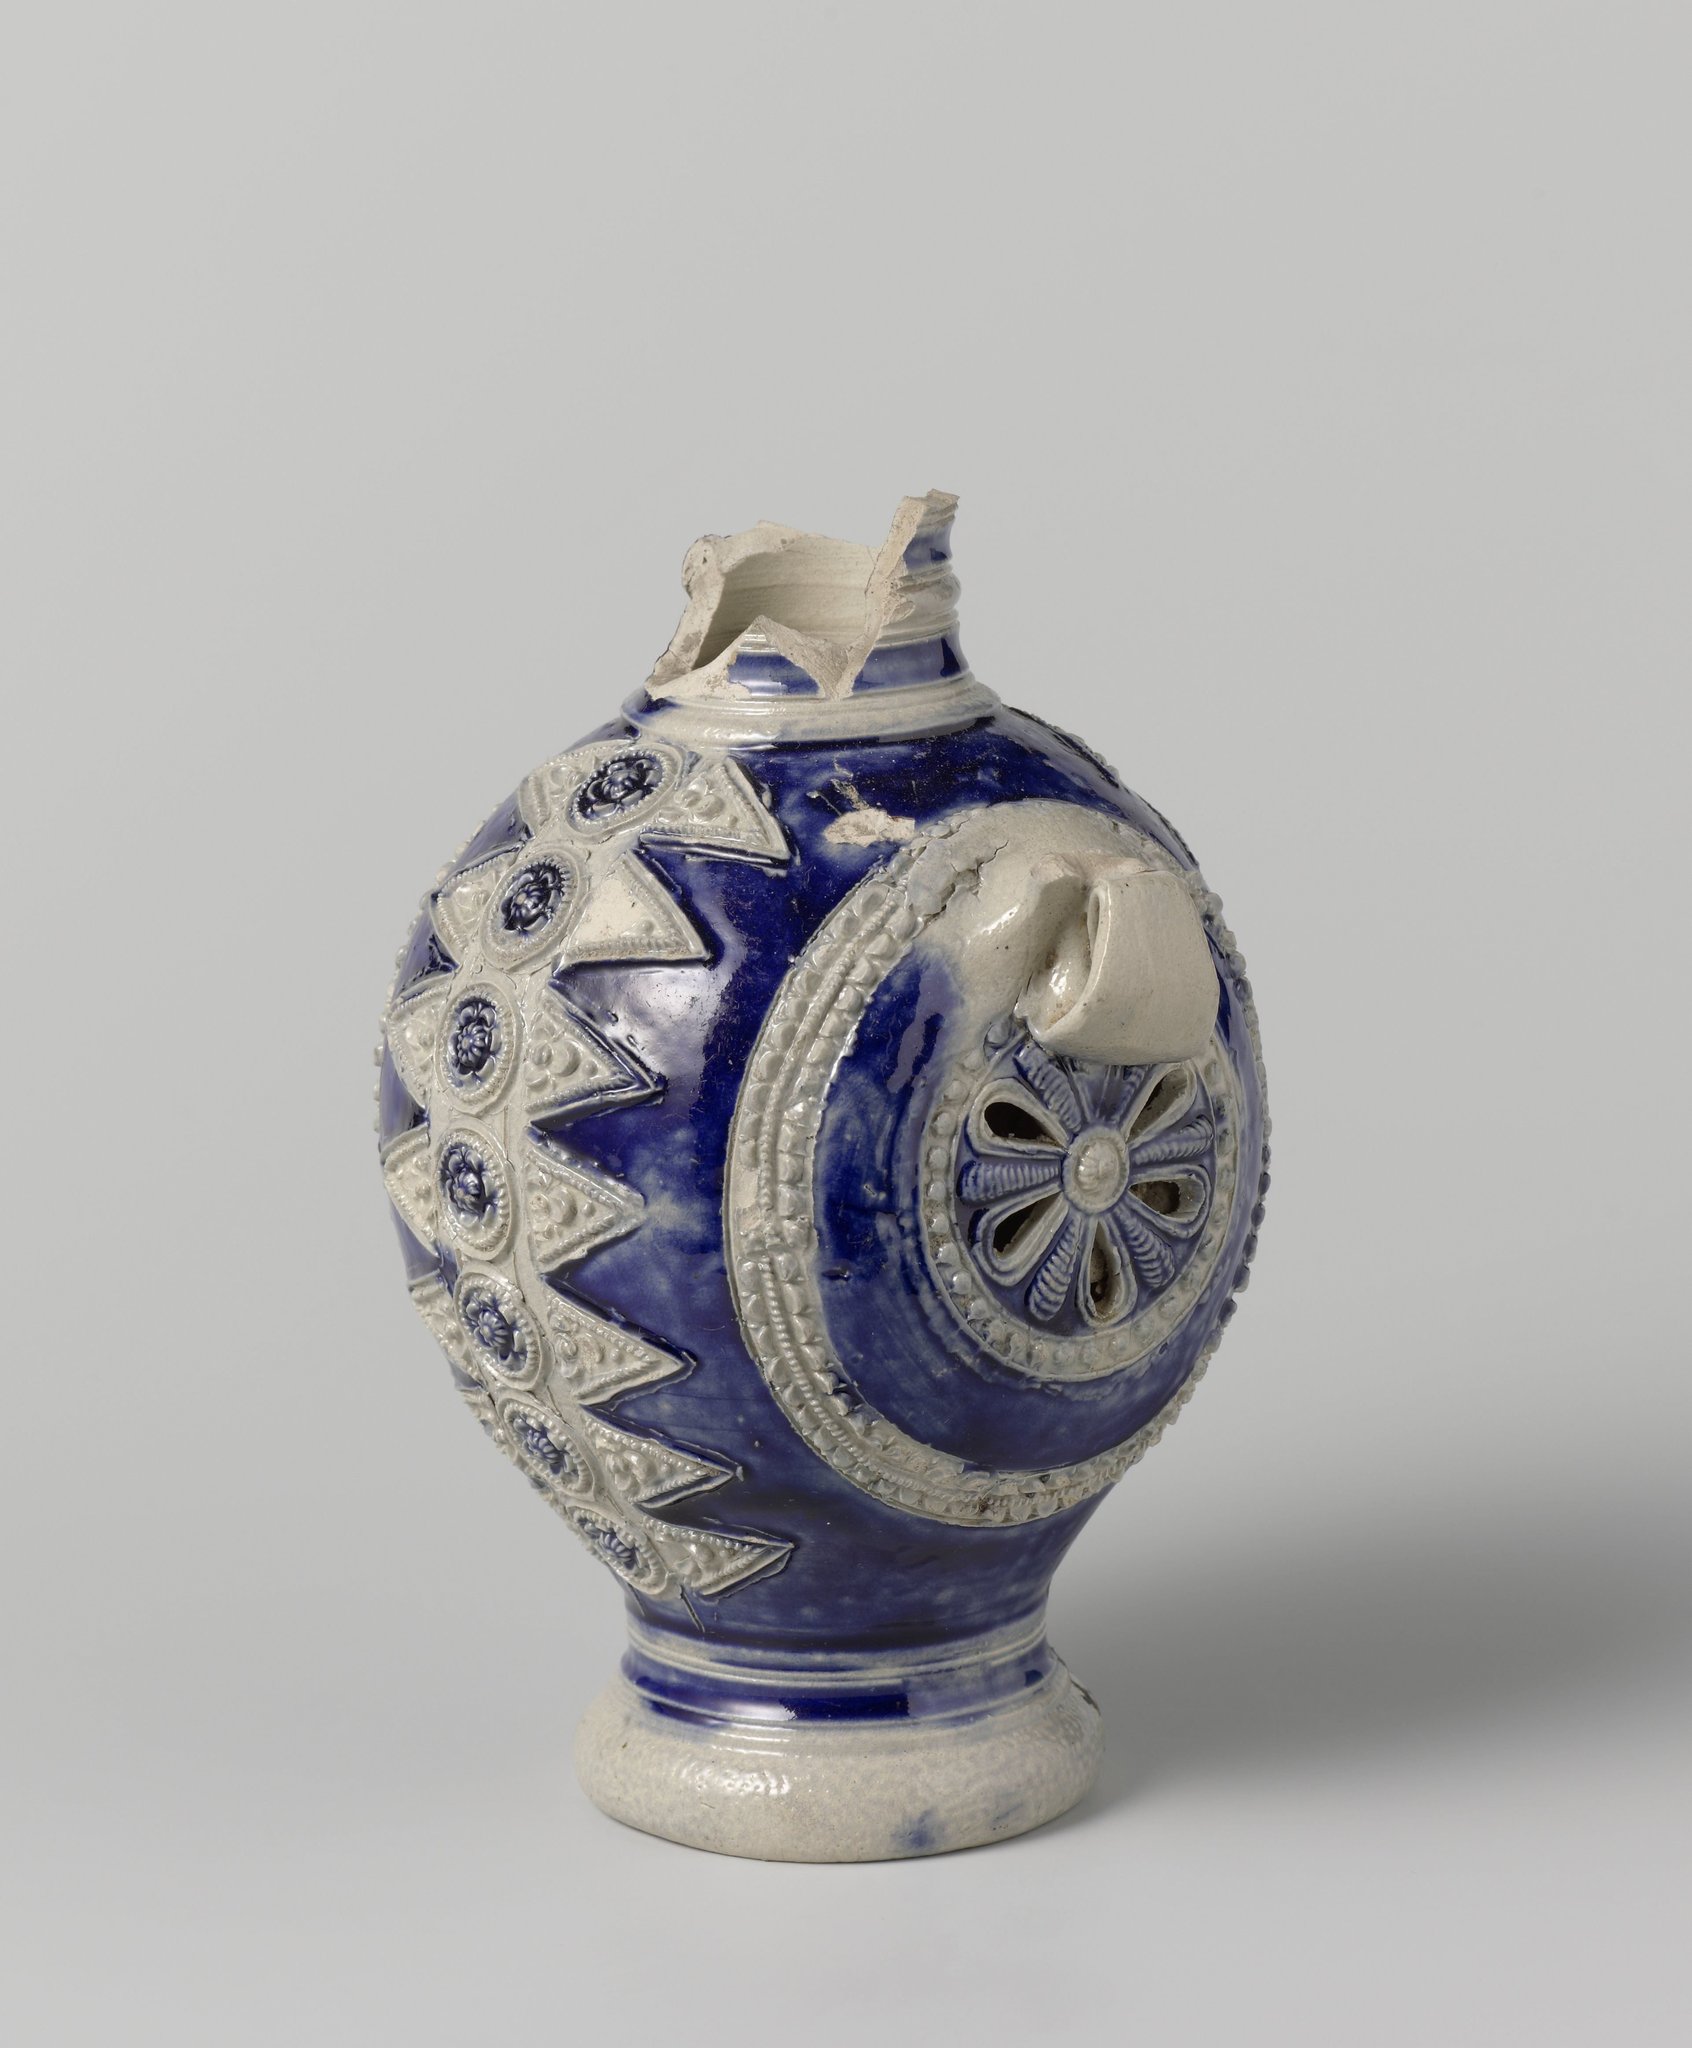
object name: ewer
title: Fragment of a jug with pierced roundels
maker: Anonymous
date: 1650-1699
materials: cobalt, glaze, stoneware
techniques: firing, forming, relief, turning, vitrification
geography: westerwald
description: Fragment van een kan van steengoed op hoge voet met een bolvormige buik. Het oor en de nek ontbreken. Profielen op de nek en voet. Gedeeltelijk bedekt met kobaltblauw. Op beide zijden van de buik een enigszins afgeplat, dubbelwandig gedeelte met een opengewerkte rozet omgeven door twee gedrukte en opgelegde cirkels in reliëf. Één met stippen en één doorlopende bladrank. Tussen beide zijden een verticale band met gedrukte en opgelegde medaillons met een bloem omgeven door driehoeken, die ook gevuld zijn met een bloem. Westerwald.